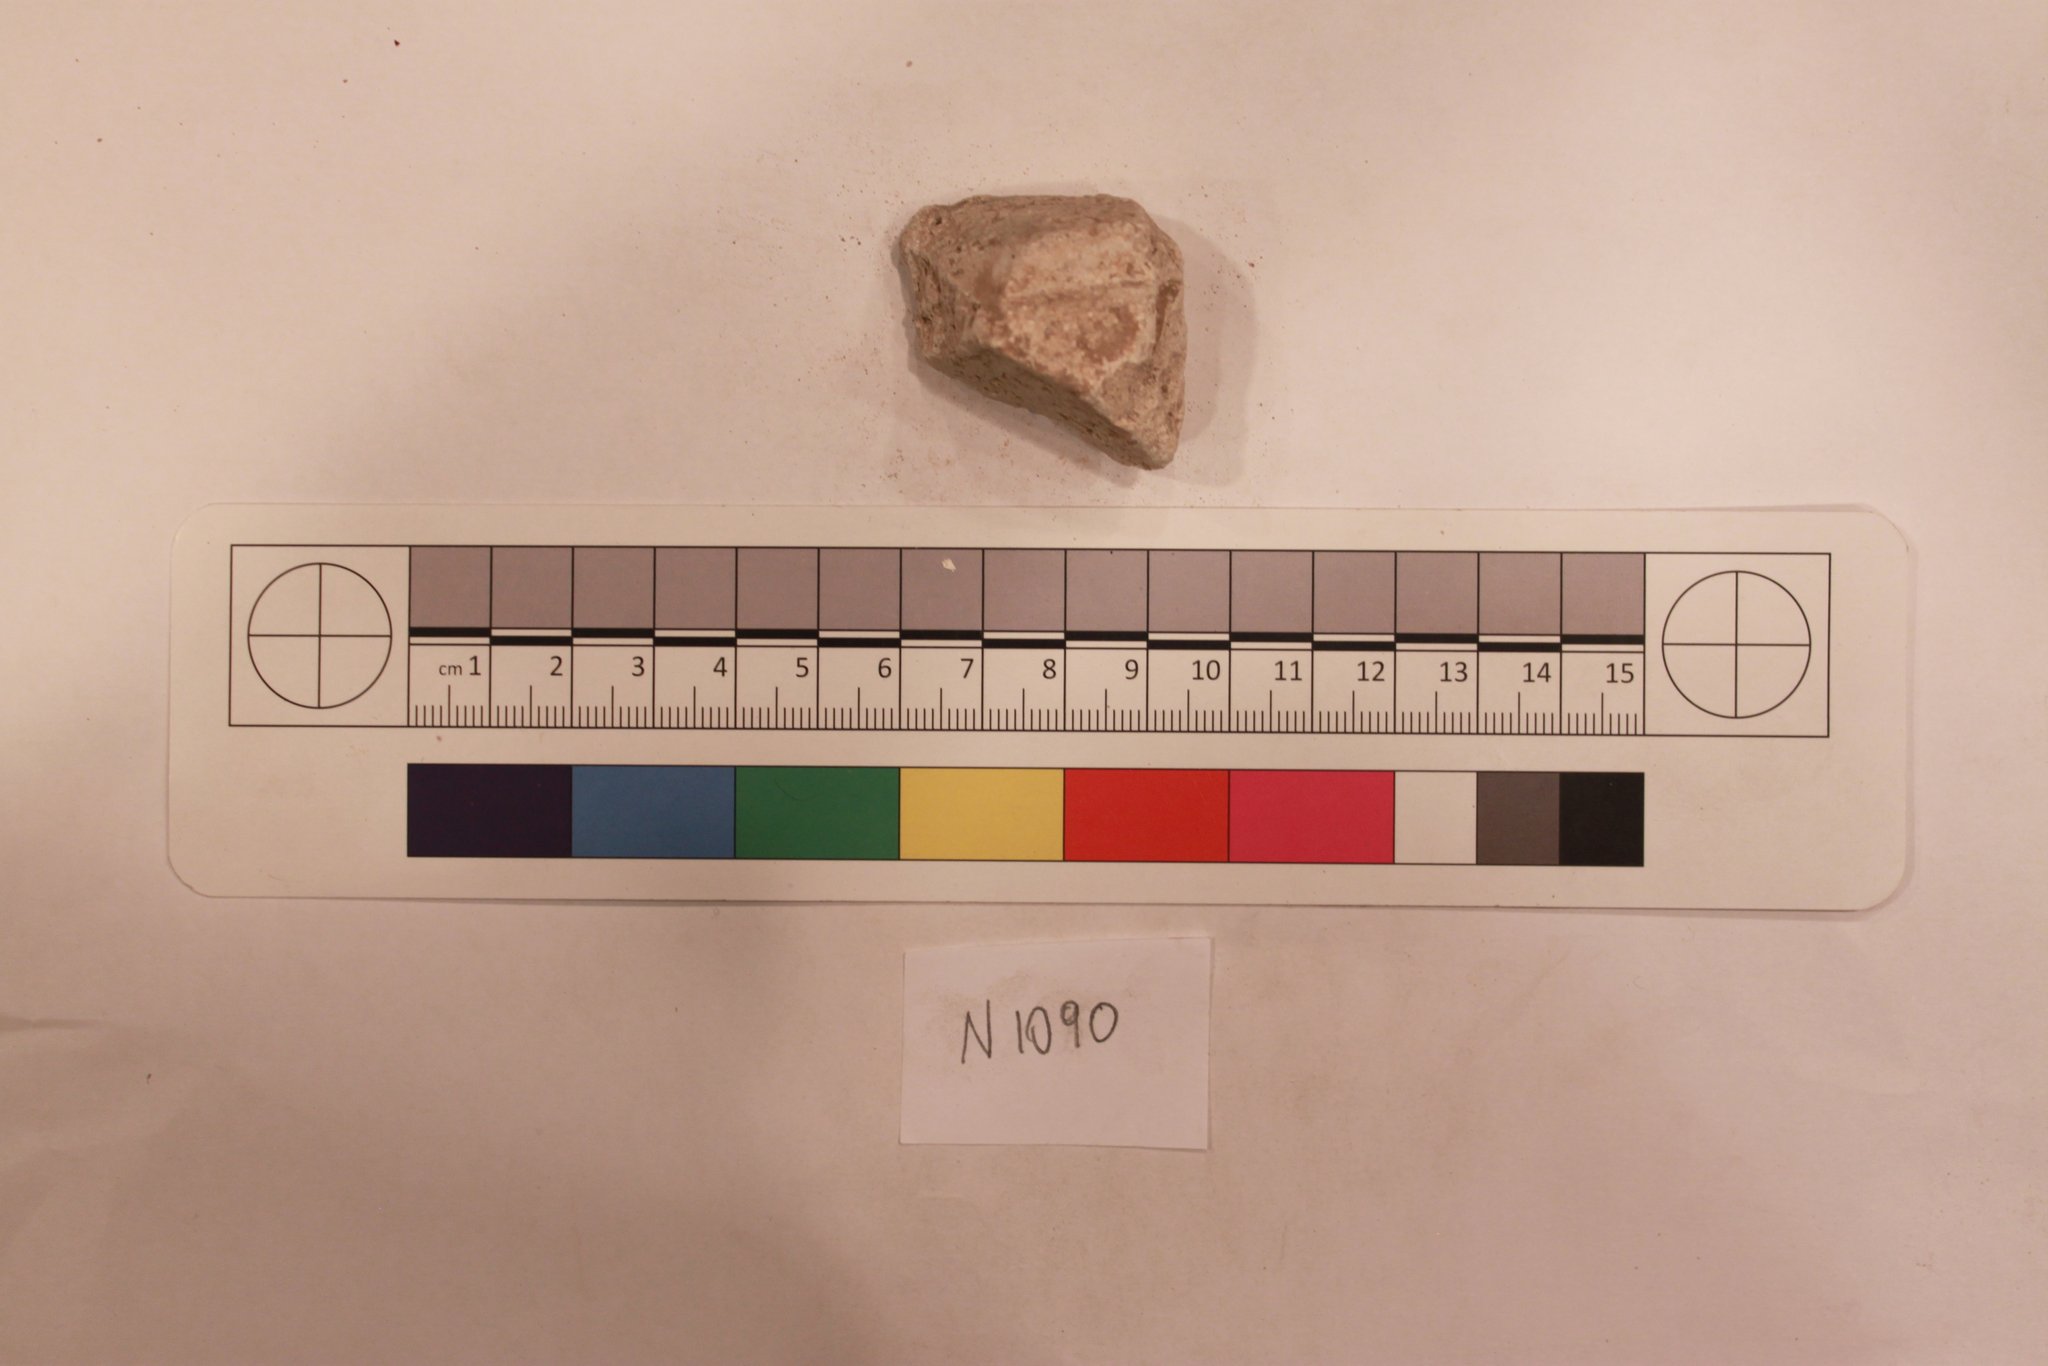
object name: fragment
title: Stucco Fragment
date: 701-1200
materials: plaster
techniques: carving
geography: iran